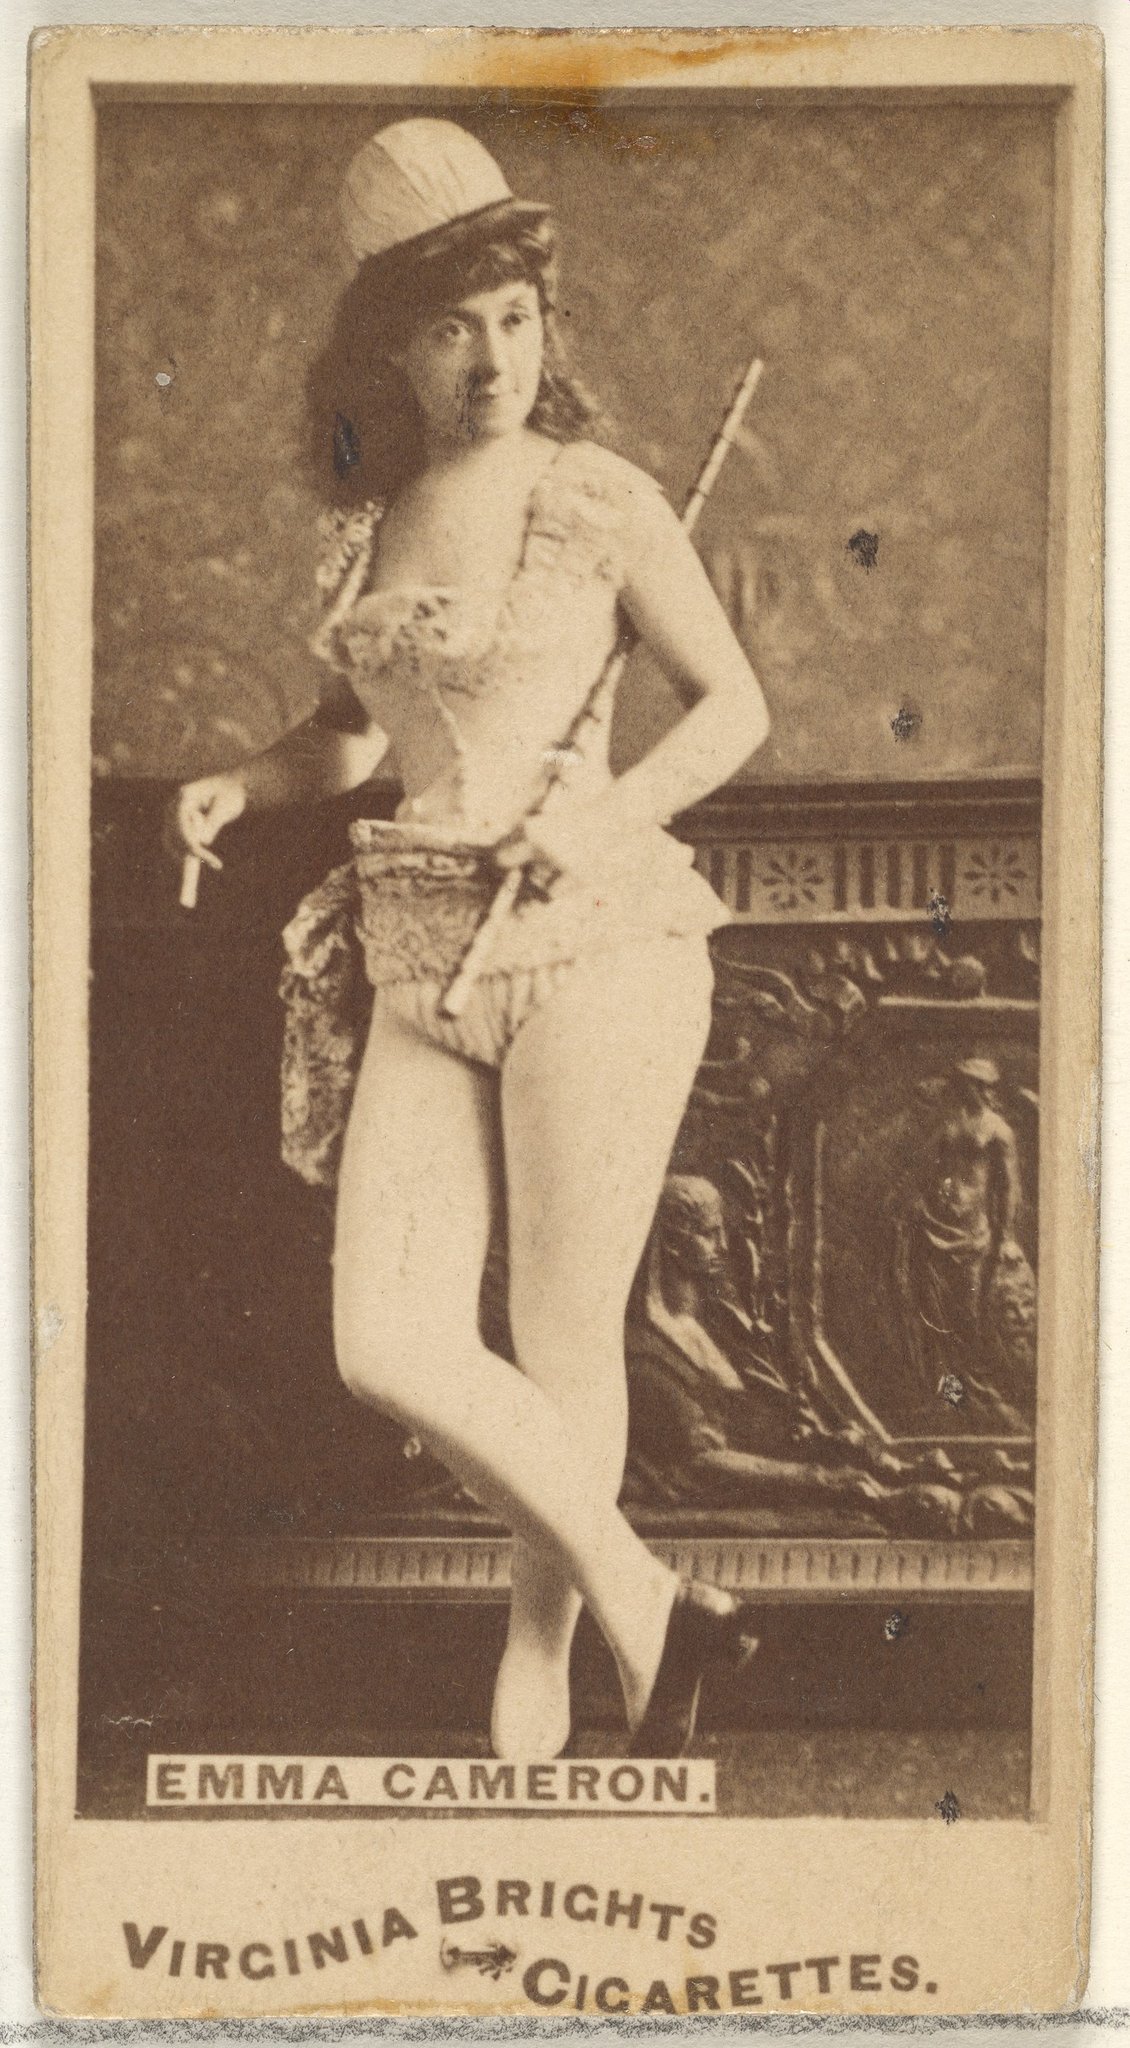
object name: photograph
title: Emma Cameron, from the Actors and Actresses series (N45, Type 1) for Virginia Brights Cigarettes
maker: allen & ginter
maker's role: publisher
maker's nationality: american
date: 1888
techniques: albumen silver print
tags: portraits,women,actresses